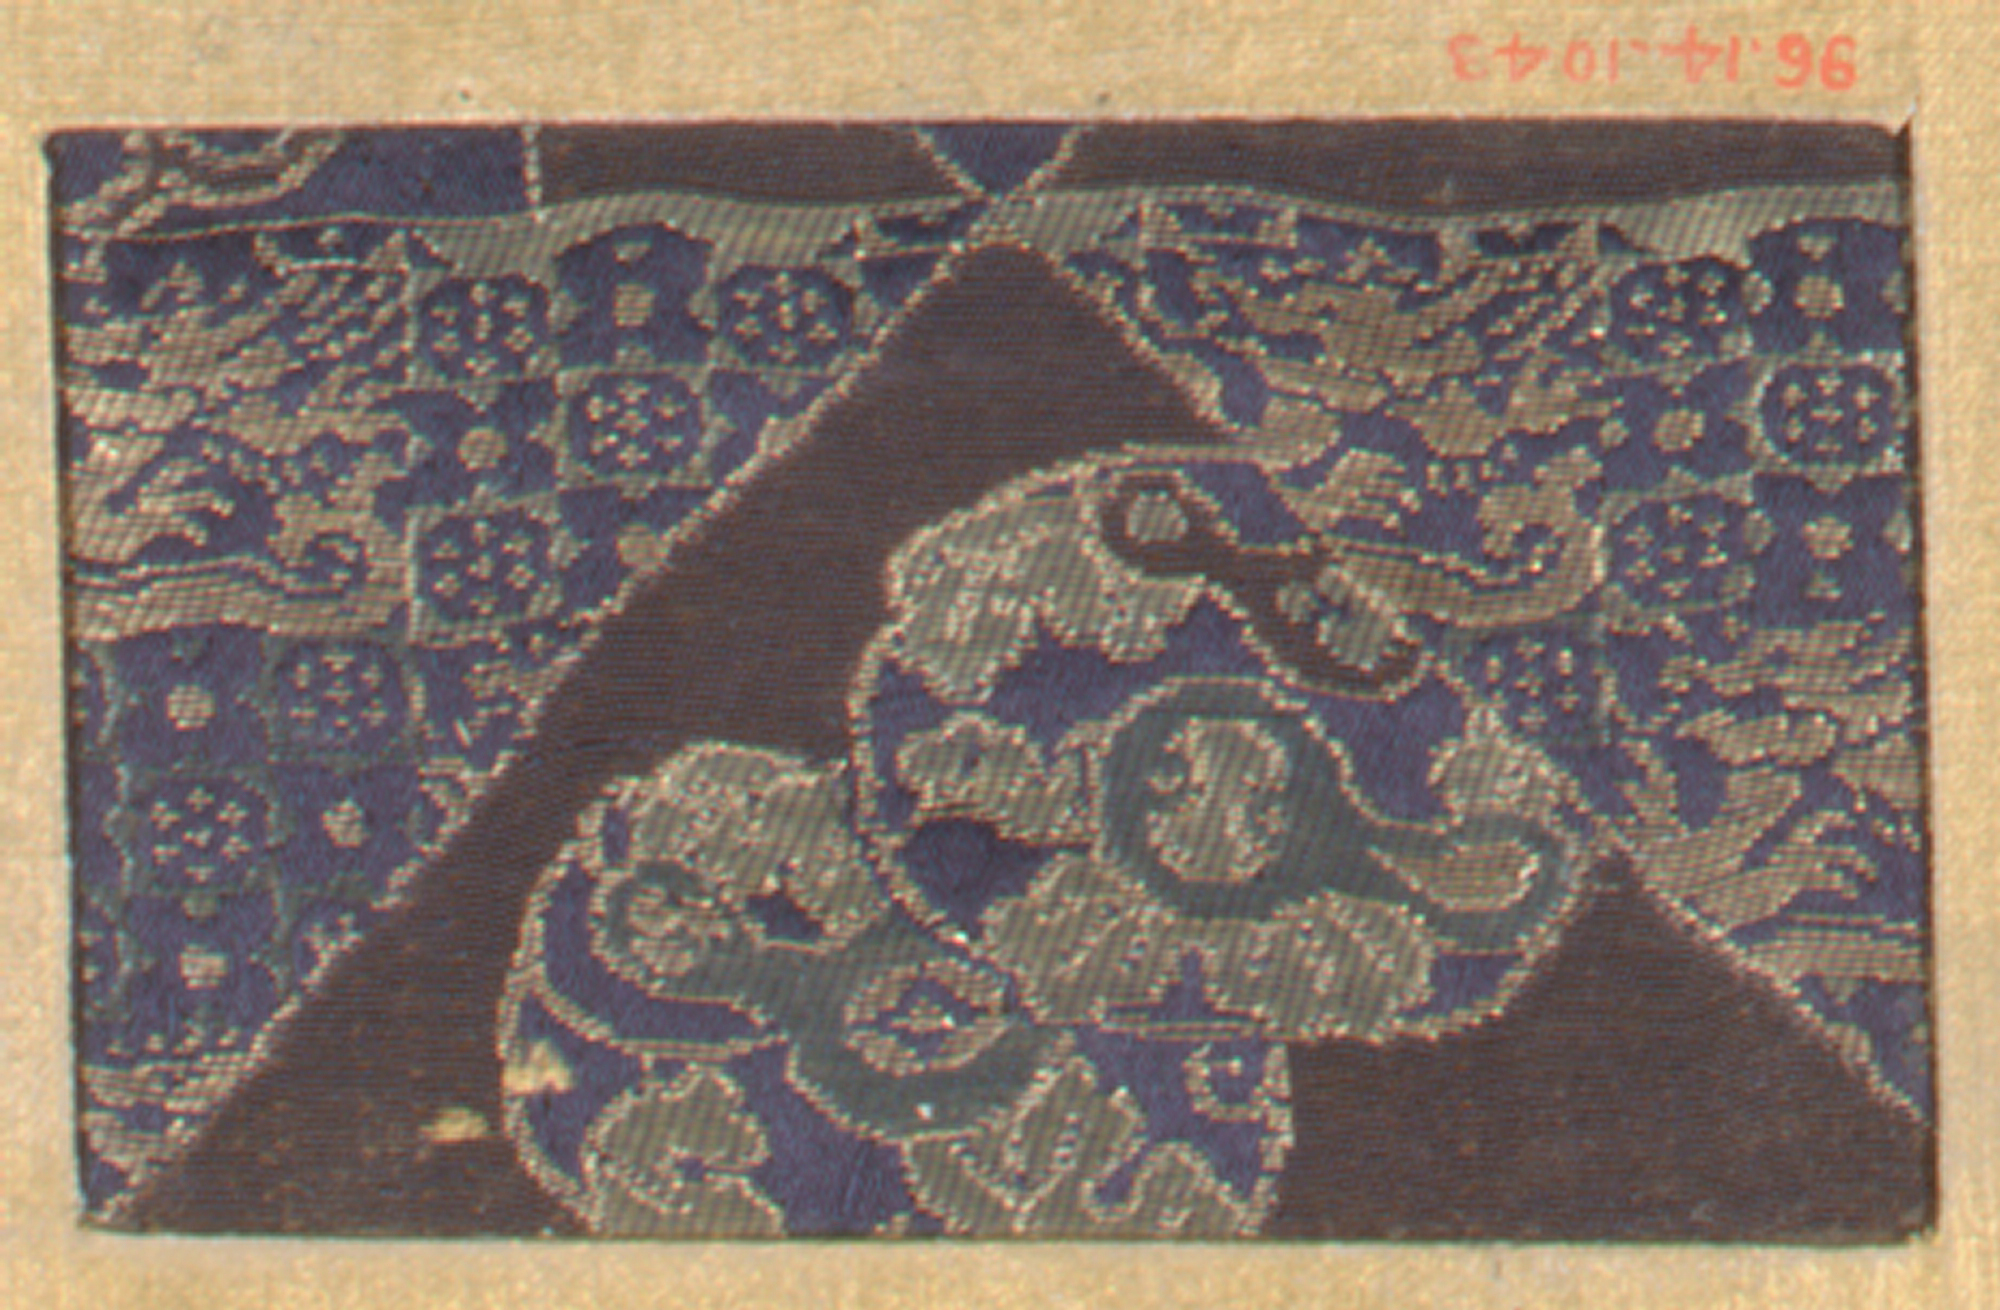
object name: piece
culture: japanese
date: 1701-1900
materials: silk